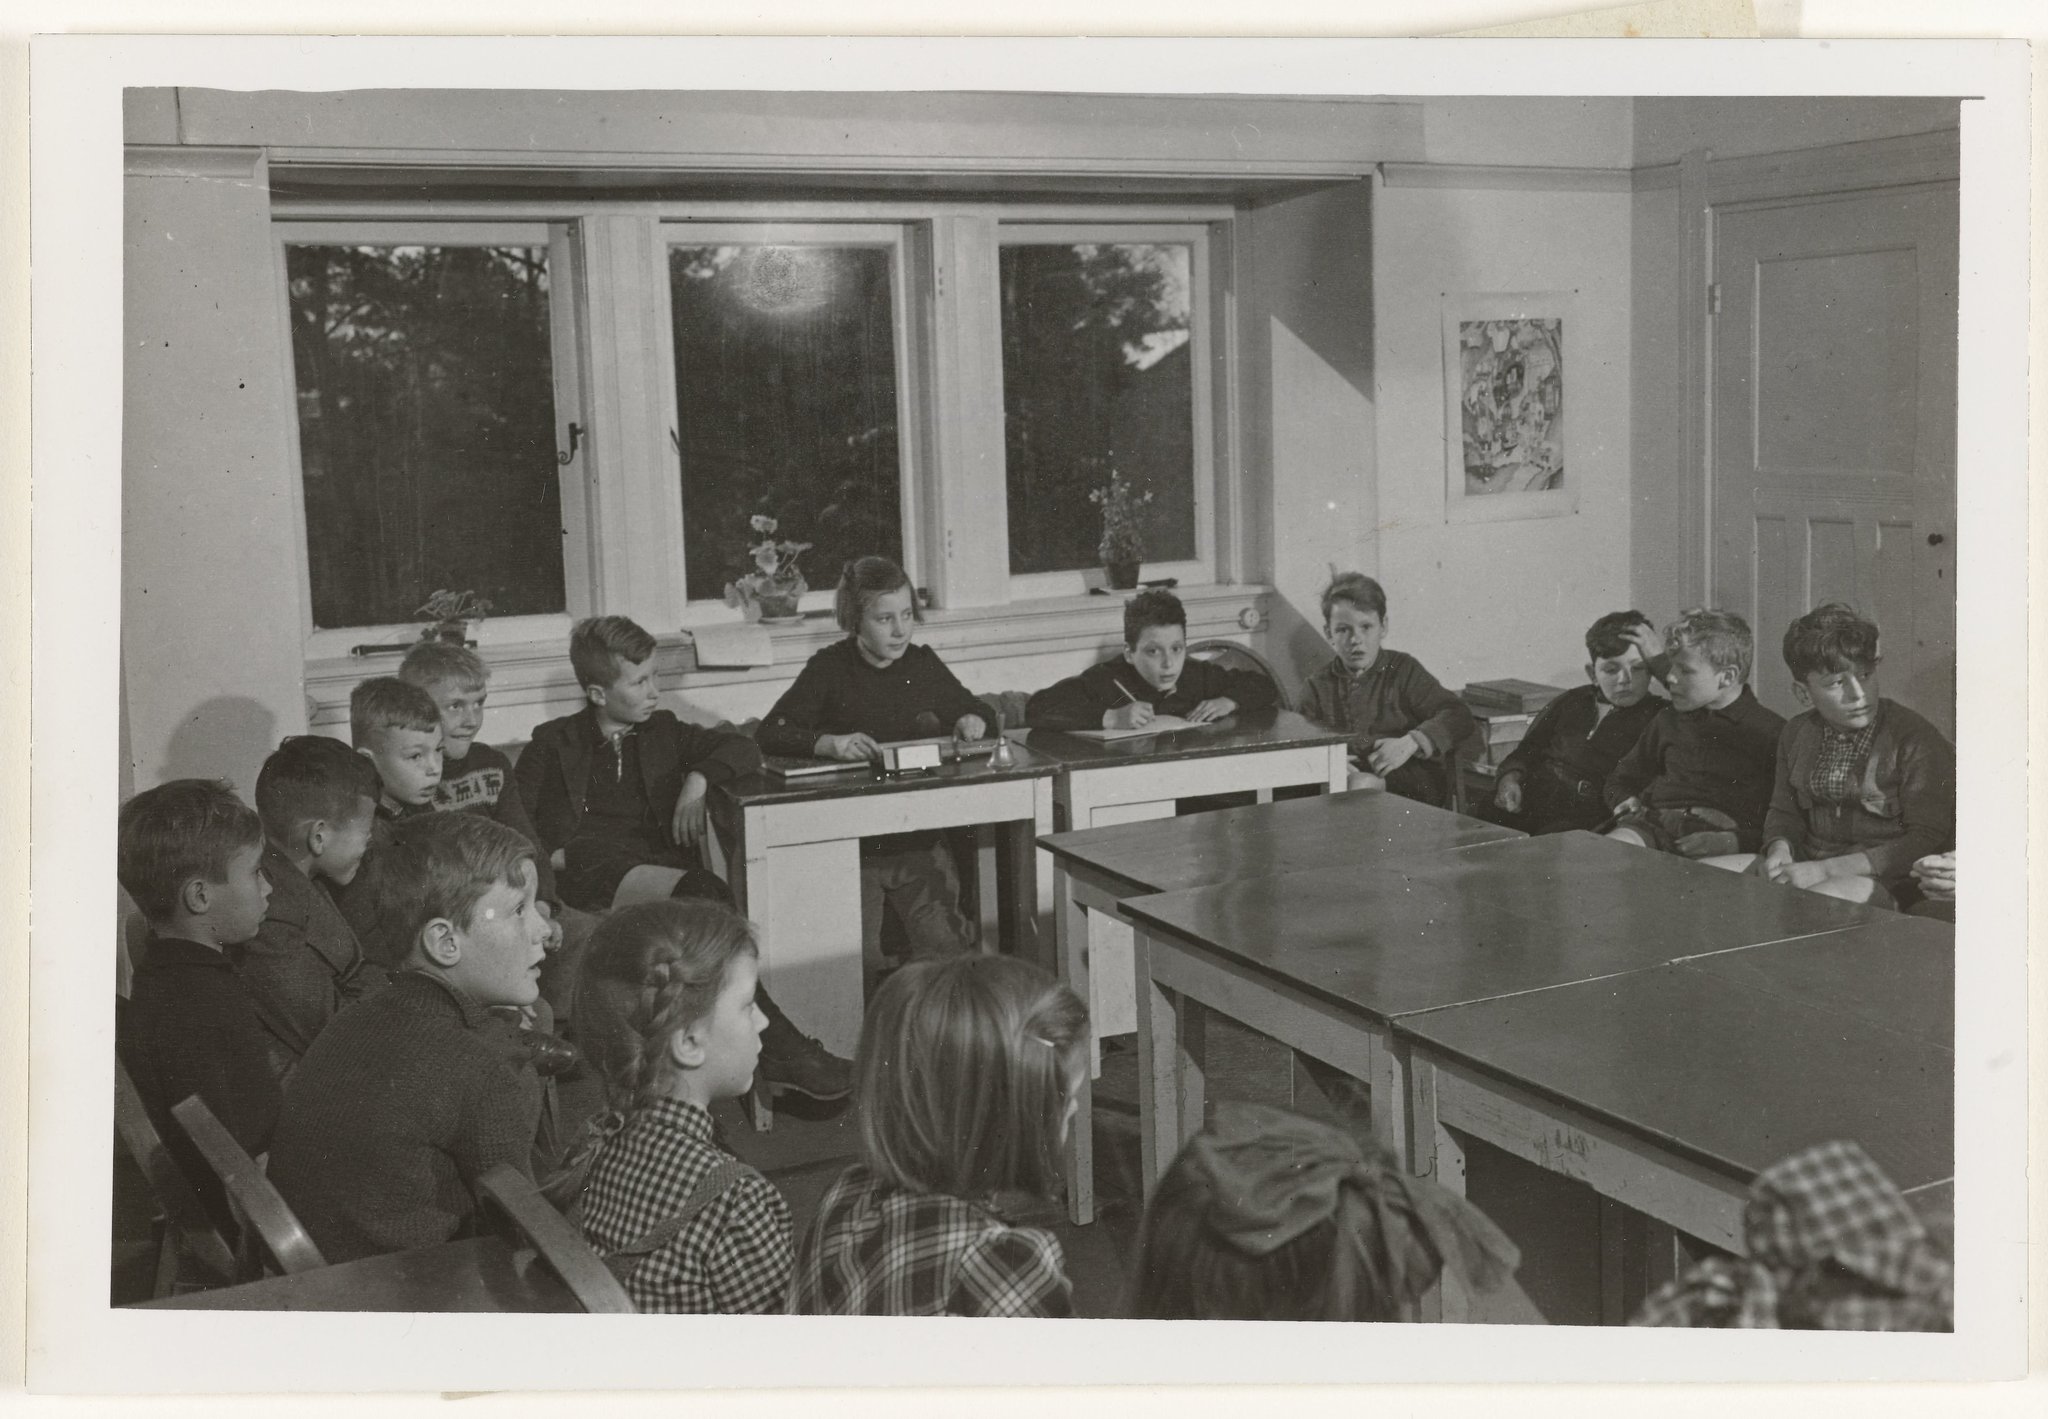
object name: photograph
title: Leerlingen van de werkplaats Kindergemeenschap Bilthoven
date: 1946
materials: photographic support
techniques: photography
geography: bilthoven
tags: alkmaar, cornelis boeke, werkplaats kindergemeenschap bilthoven, bilthoven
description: Leerlingen van de Werkplaats Kindergemeenschap Bilthoven, ook genoemd de Werkplaats Kees Boeke, tijdens een bespreking. Een leerling maakt aantekeningen.